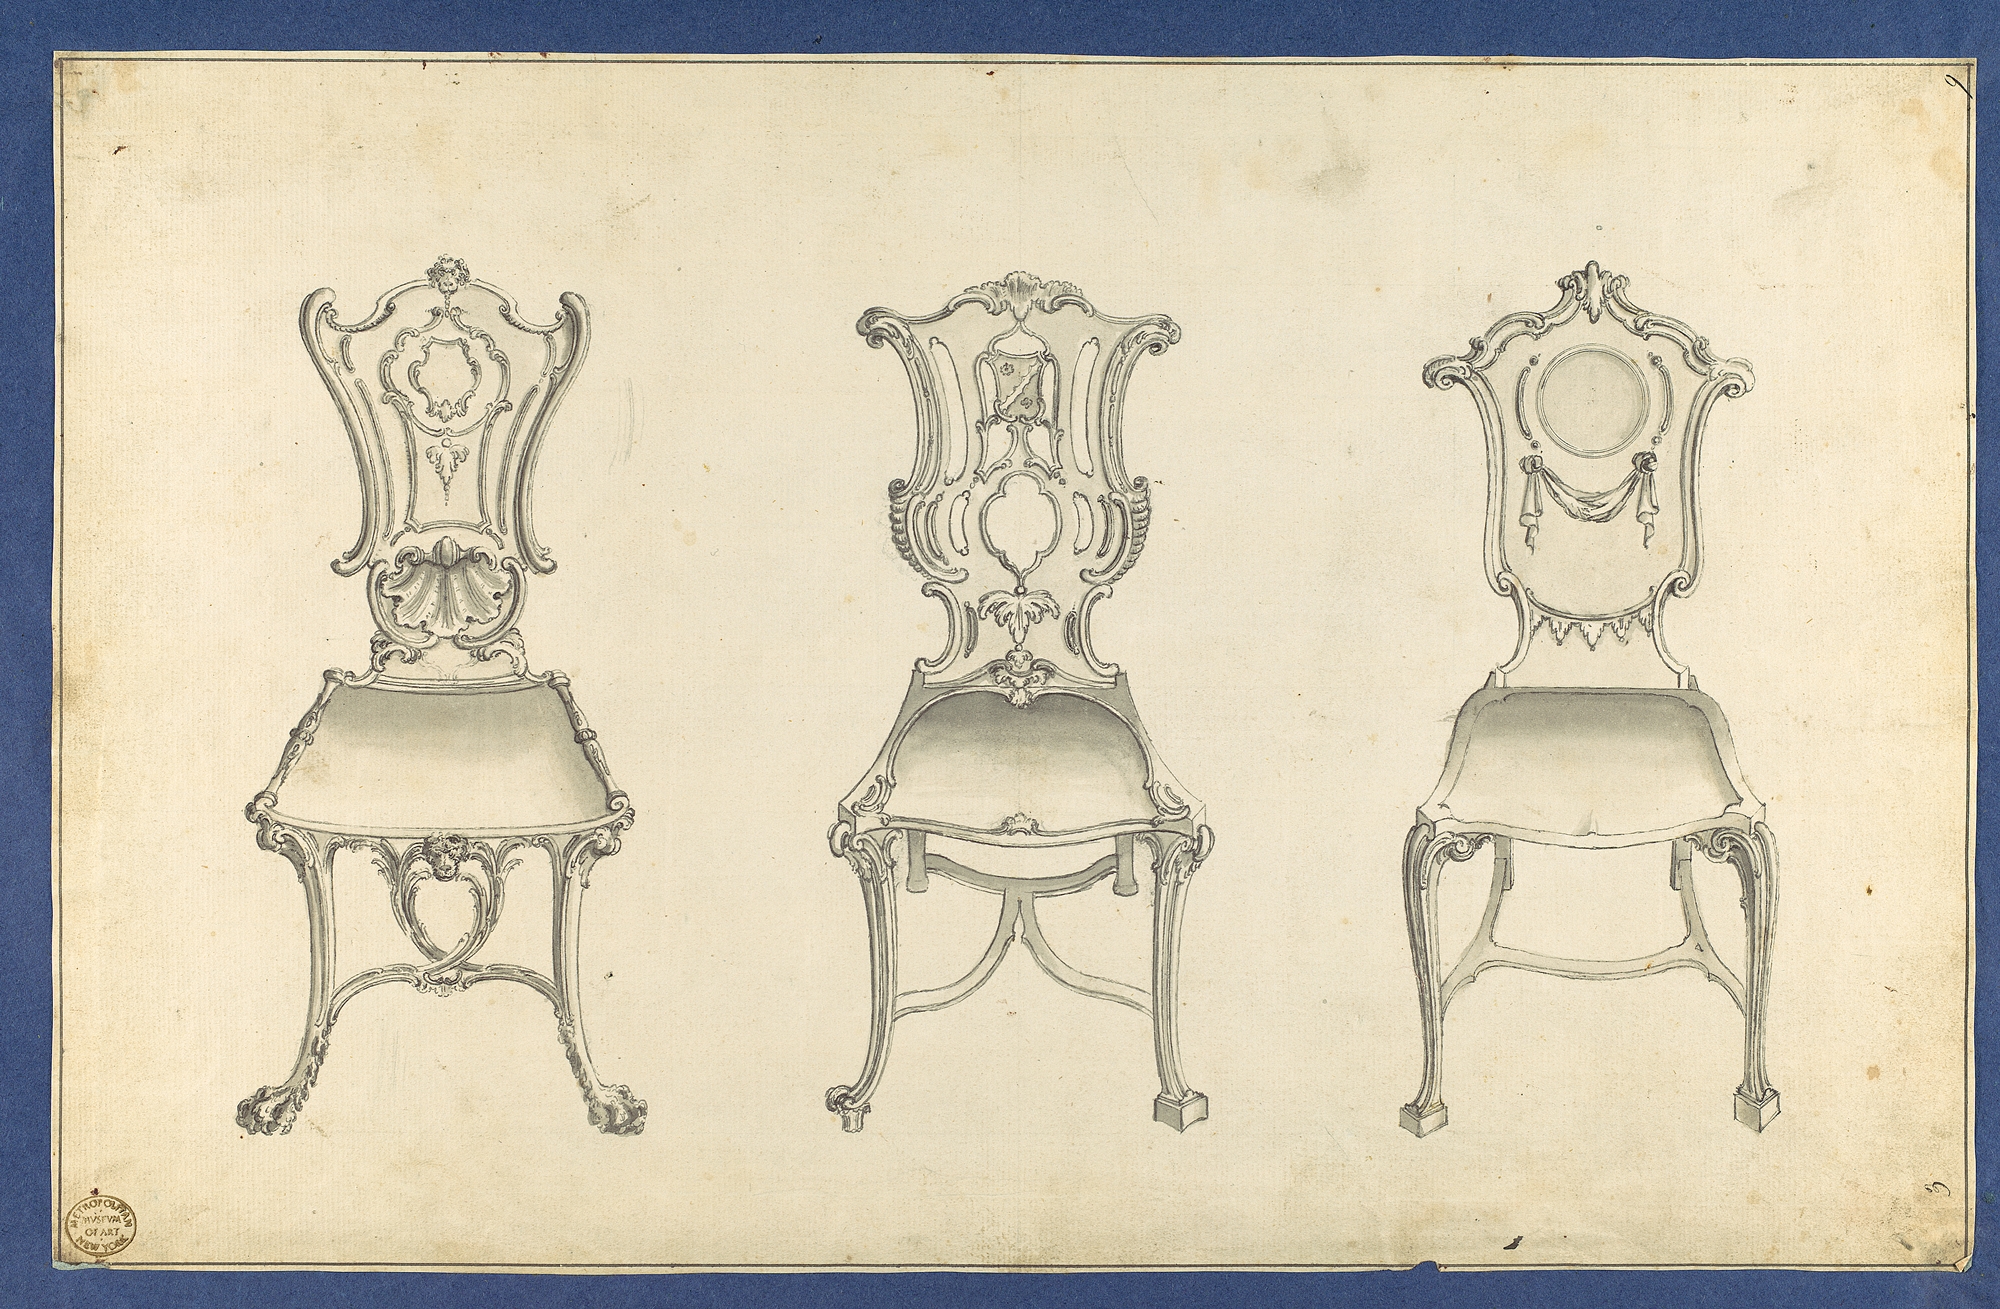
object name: drawing ornament architecture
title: Hall Chairs, in Chippendale Drawings, Vol. I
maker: thomas chippendale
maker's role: artist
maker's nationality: british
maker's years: 1718-1779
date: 1762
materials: ink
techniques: wash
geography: london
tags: chairs